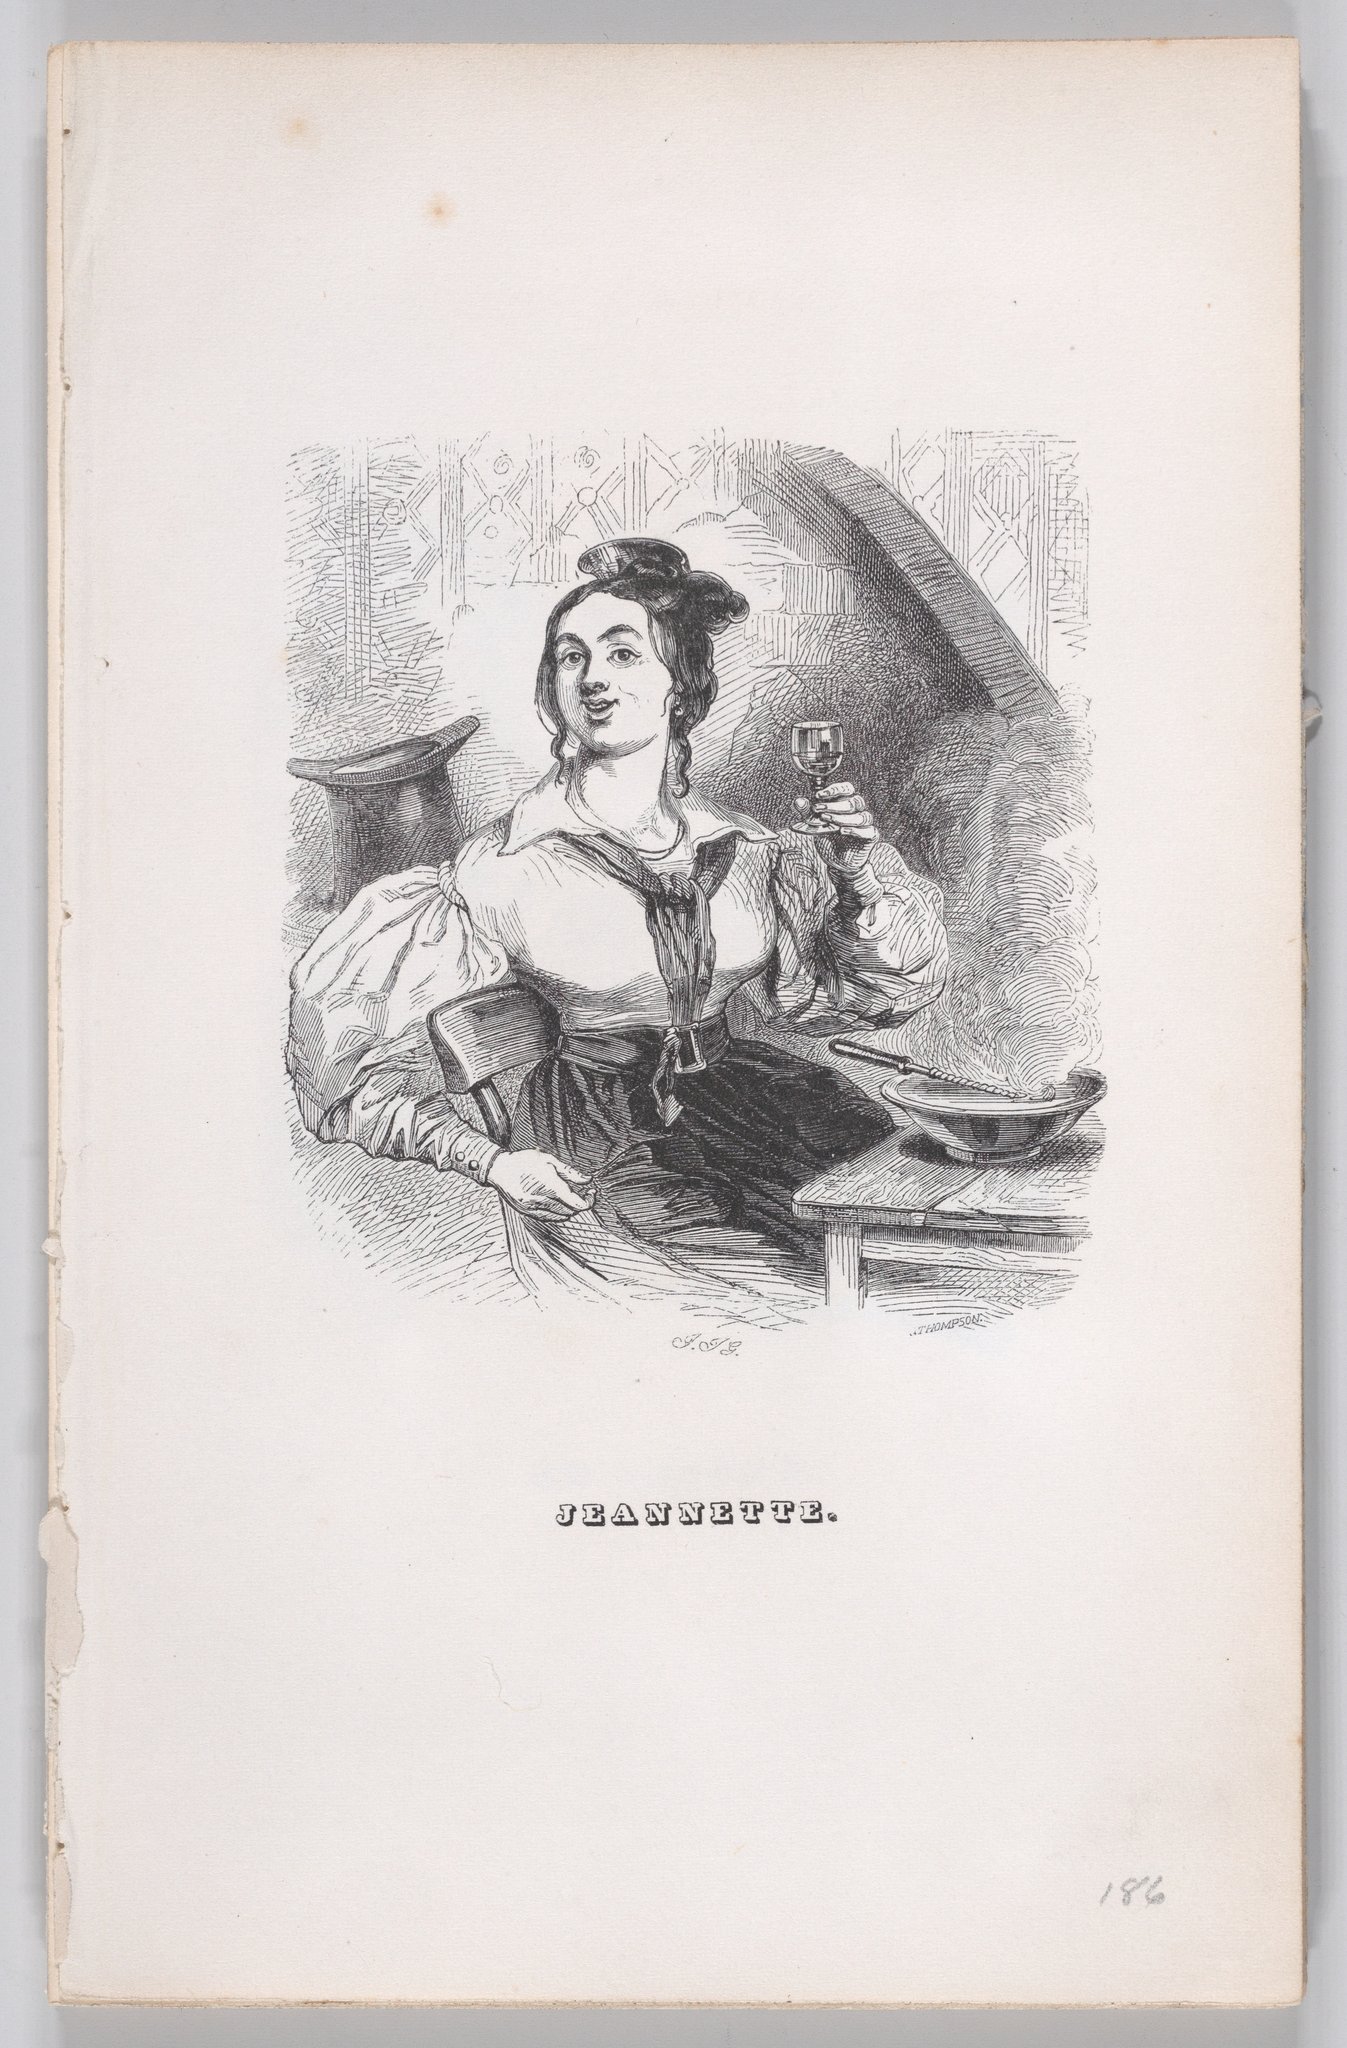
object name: print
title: Jeannette, from "The Complete Works of Béranger"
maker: j. j. grandville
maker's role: illustrator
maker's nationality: french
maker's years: 1803-1847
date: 1836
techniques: engraving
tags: women